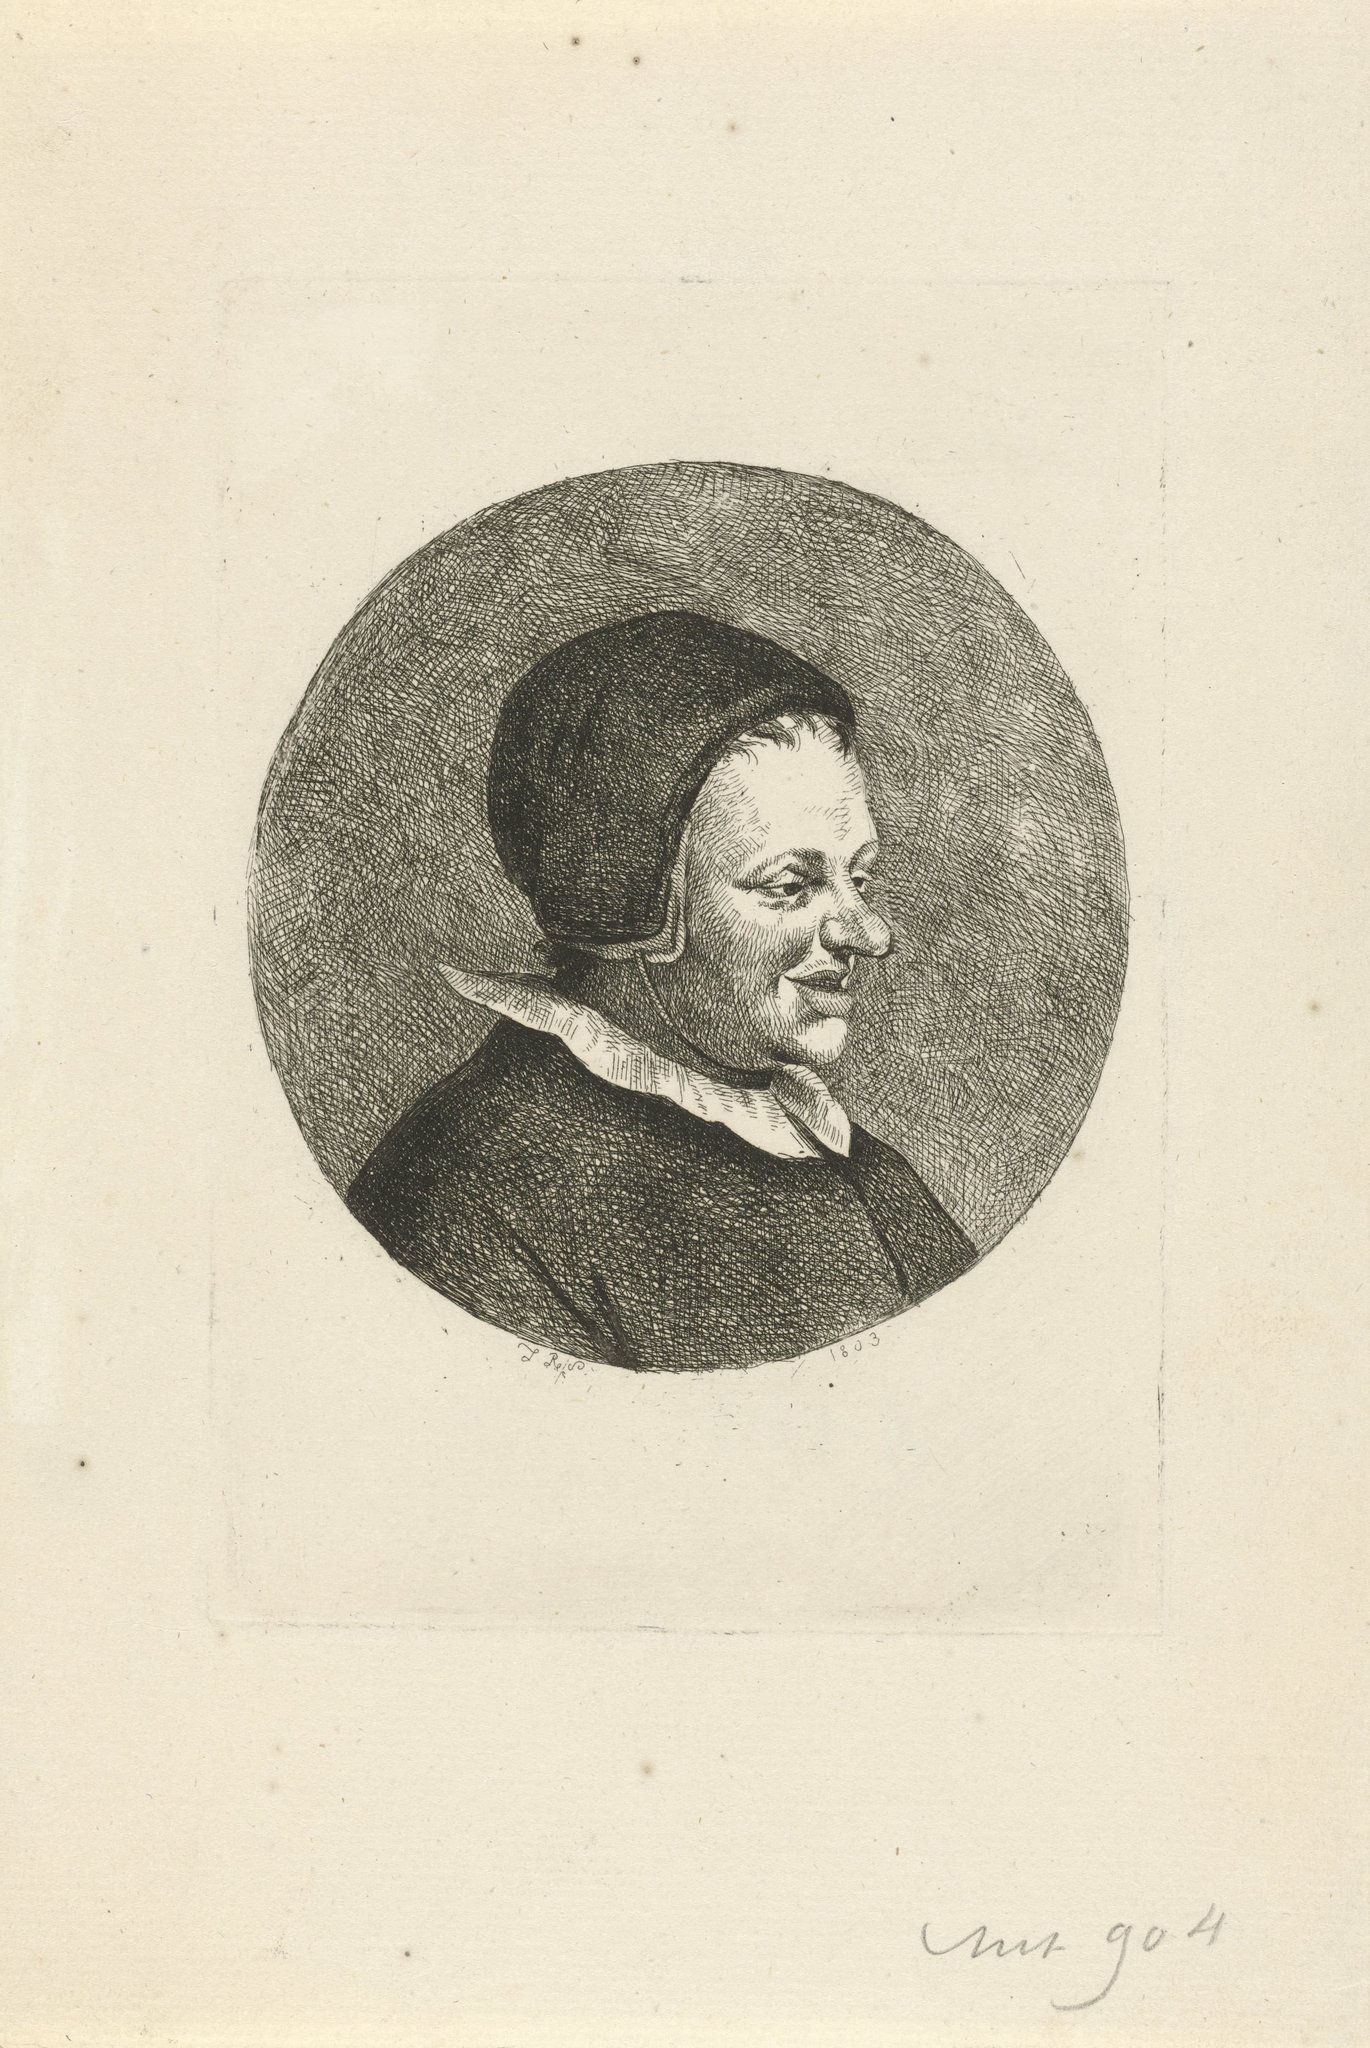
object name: print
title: Vrouwkop met kapje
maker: izaak riewert schmidt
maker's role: draughtsman, print maker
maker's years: 1781-1826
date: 1803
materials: paper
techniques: etching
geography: netherlands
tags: adult woman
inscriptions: collector's mark: Lugt 2228